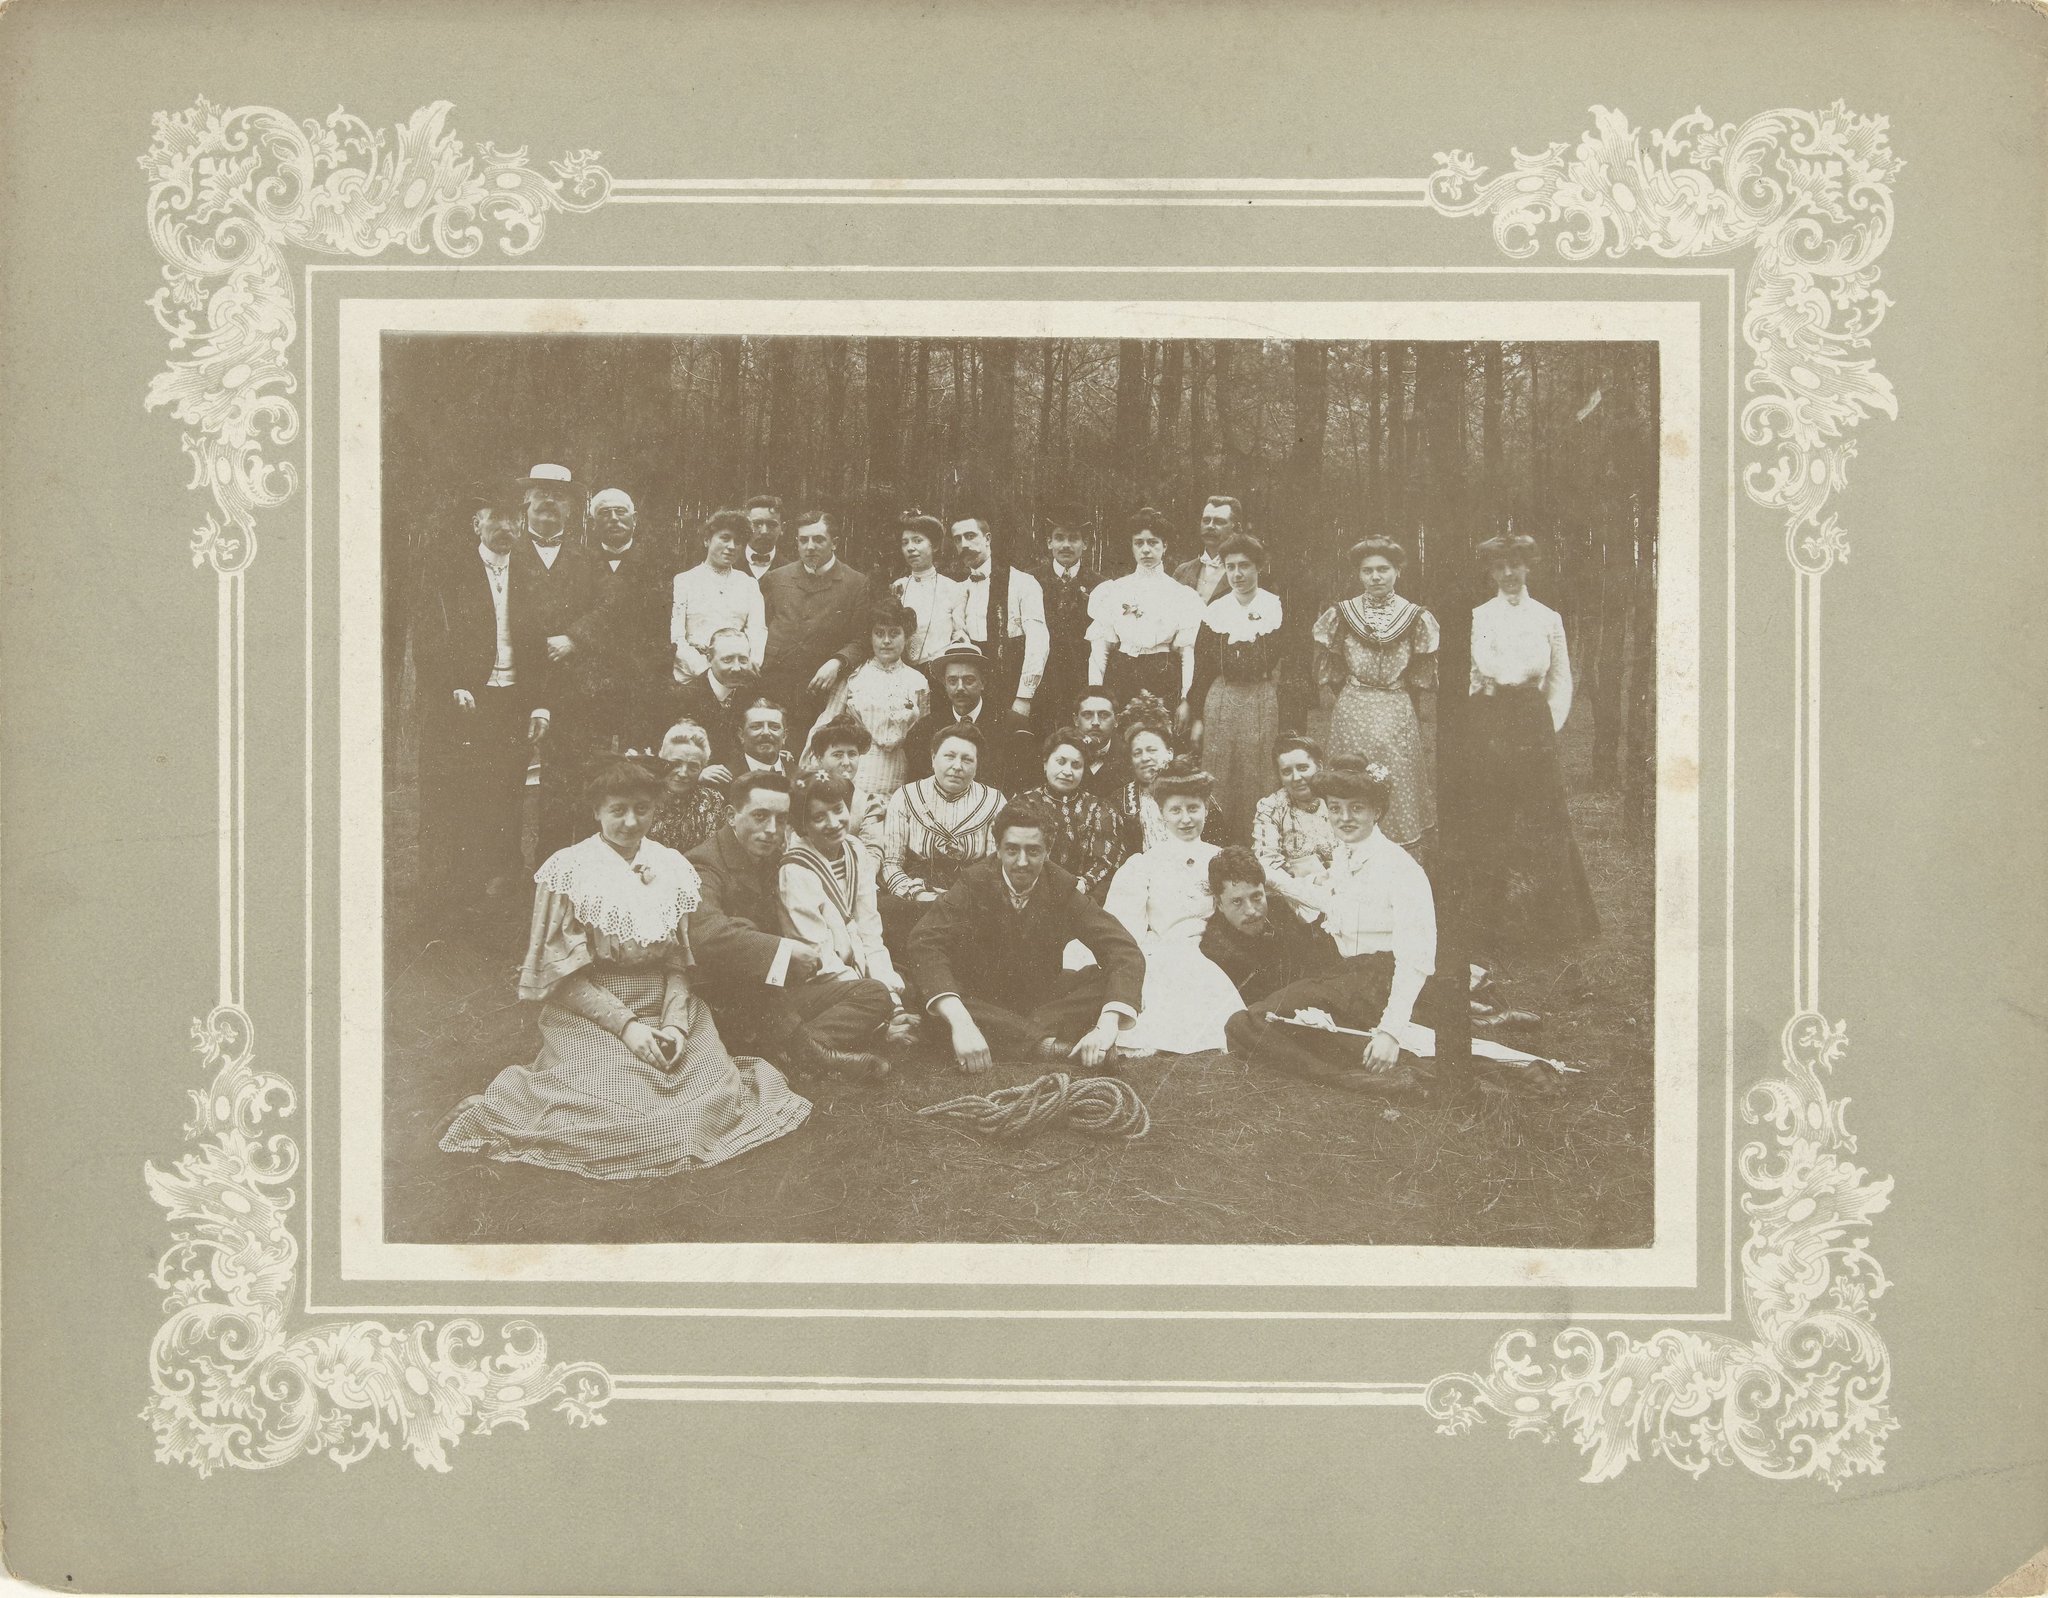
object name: photograph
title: Groepsportret van onbekende jonge mannen en vrouwen in een bos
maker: Anonymous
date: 1890-1910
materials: paper, cardboard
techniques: collodion silver print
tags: forest, wood, anonymous historical persons portrayed in a group, in a group-portrait